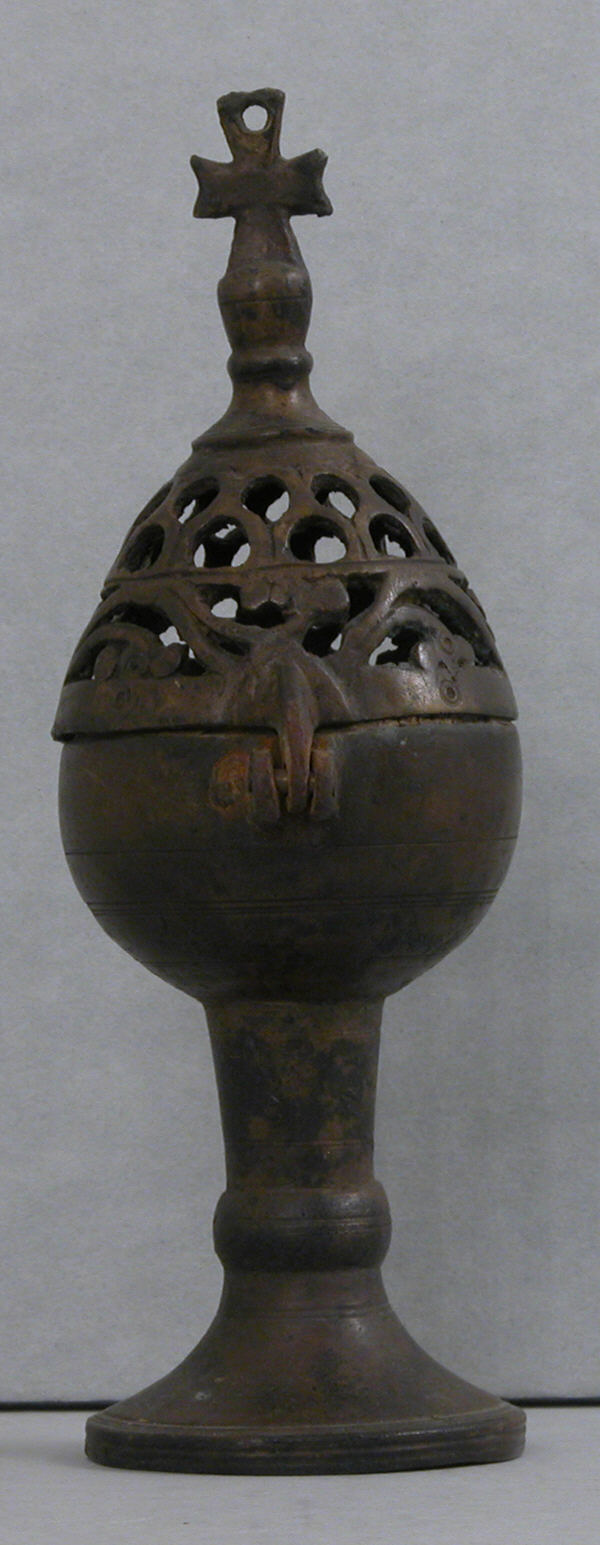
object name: censer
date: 601-700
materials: bronze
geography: egypt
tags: censers